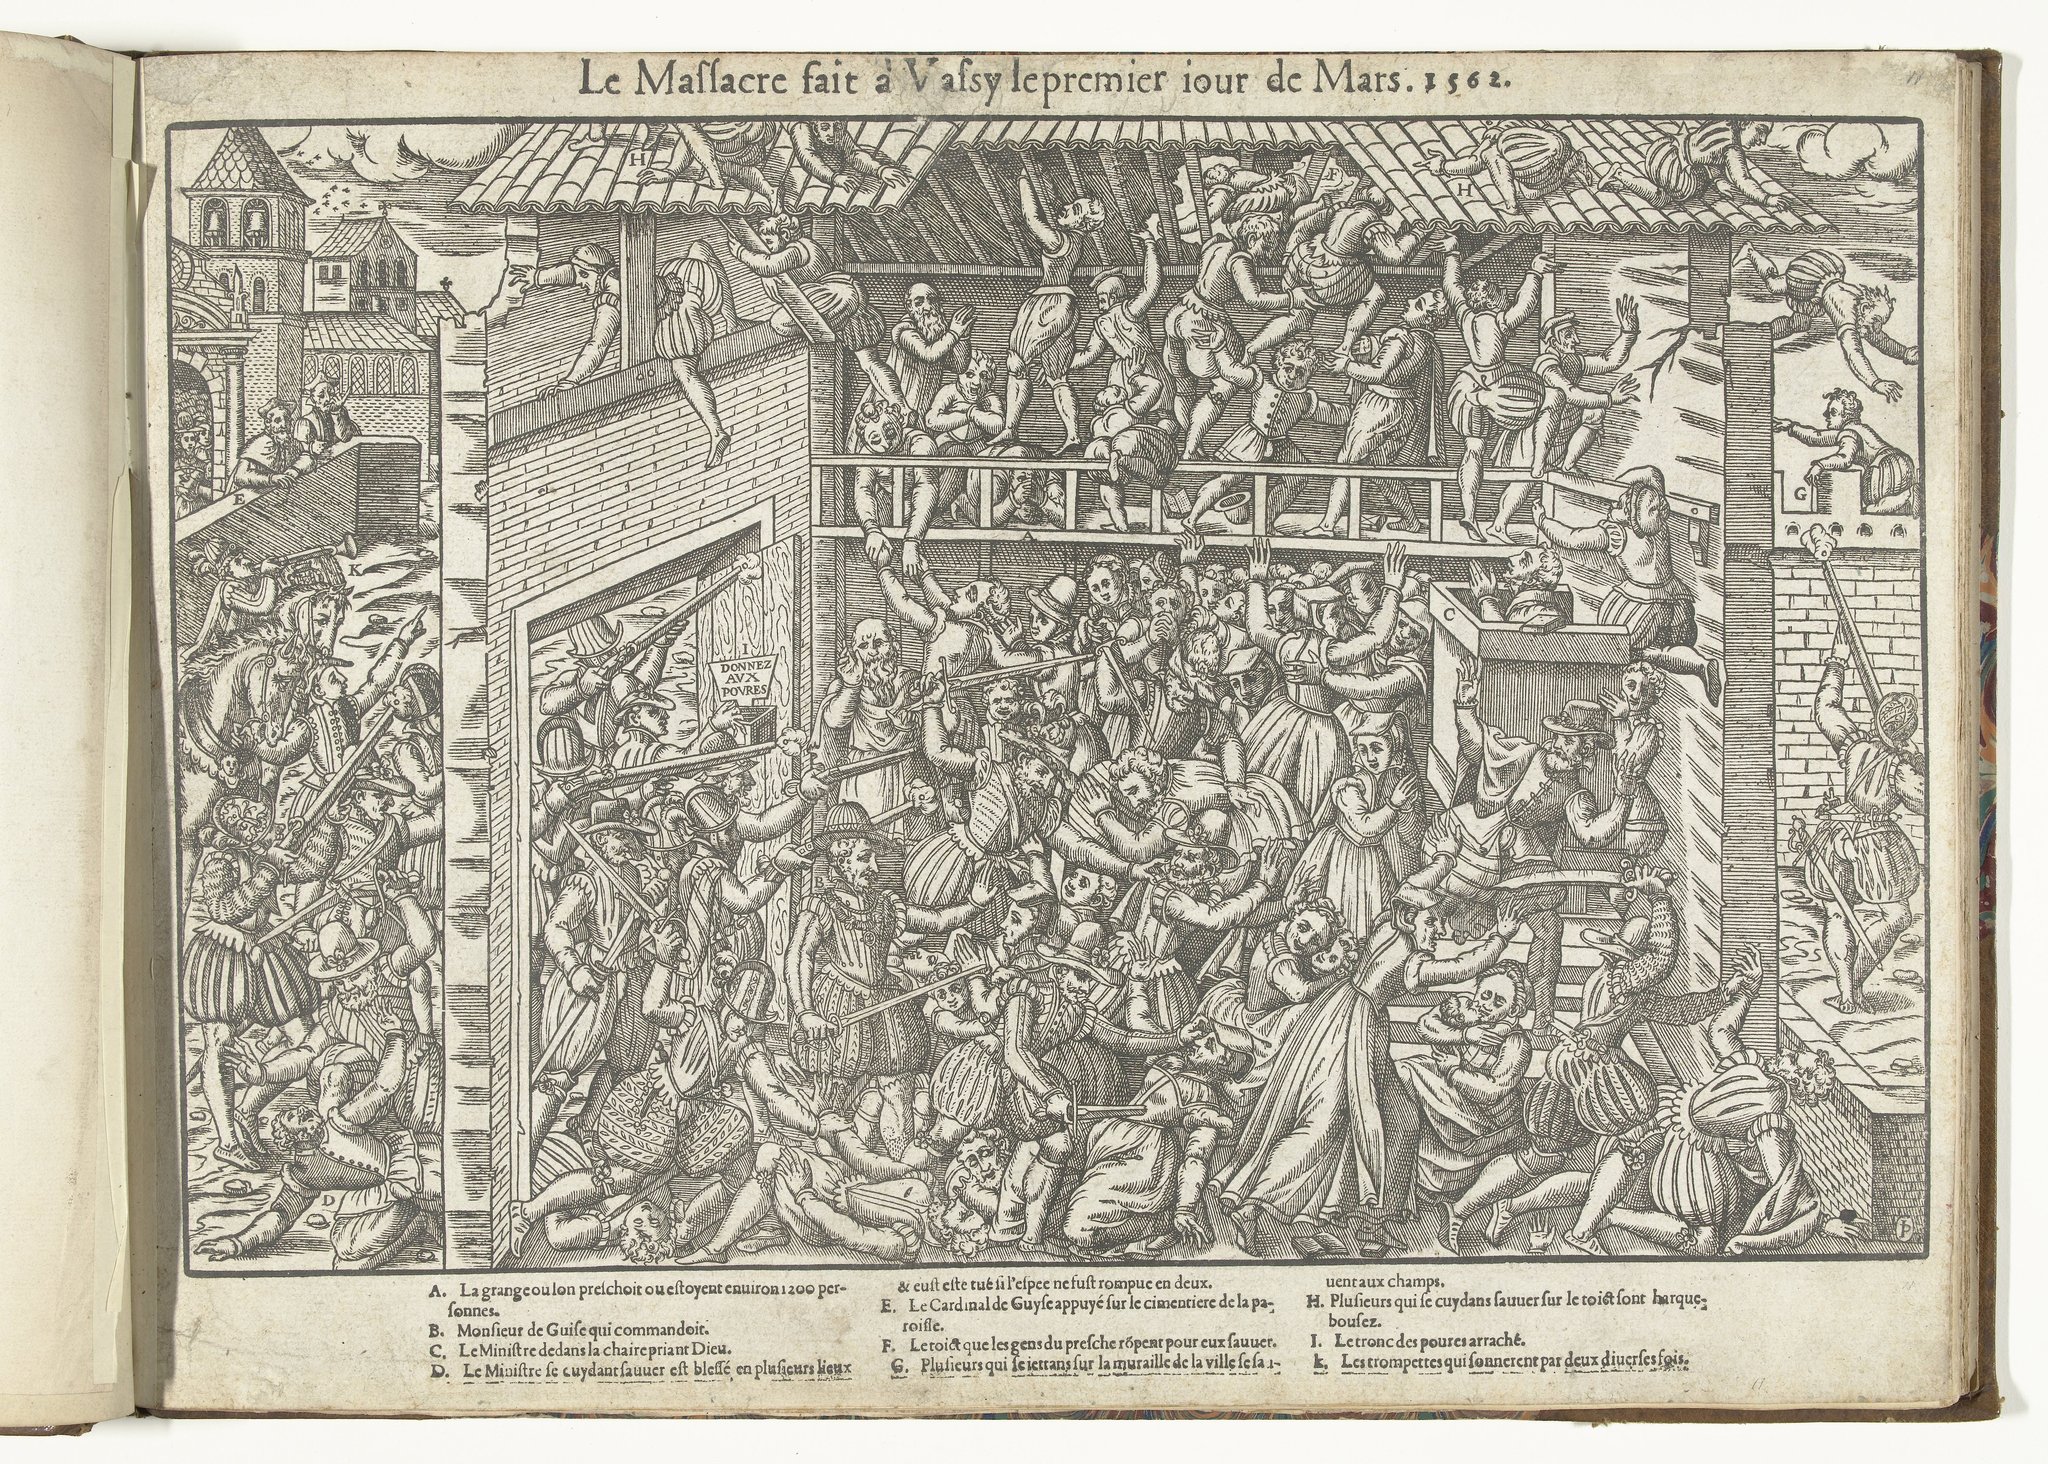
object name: history print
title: Le Massacre fait a Vassy le premier jour de Mars. 1562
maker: jean perrissin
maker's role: print maker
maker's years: 1536-1611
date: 1570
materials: paper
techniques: letterpress printing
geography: france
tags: massacre ~ war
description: Moord op de protestanten tijdens een bijeenkomst te Wassy (Wassy-sur-Blaise), 1 maart 1562, door soldaten van de hertog de Guise. In het onderschrift de legenda A-K in het Frans. Ongenummerd.